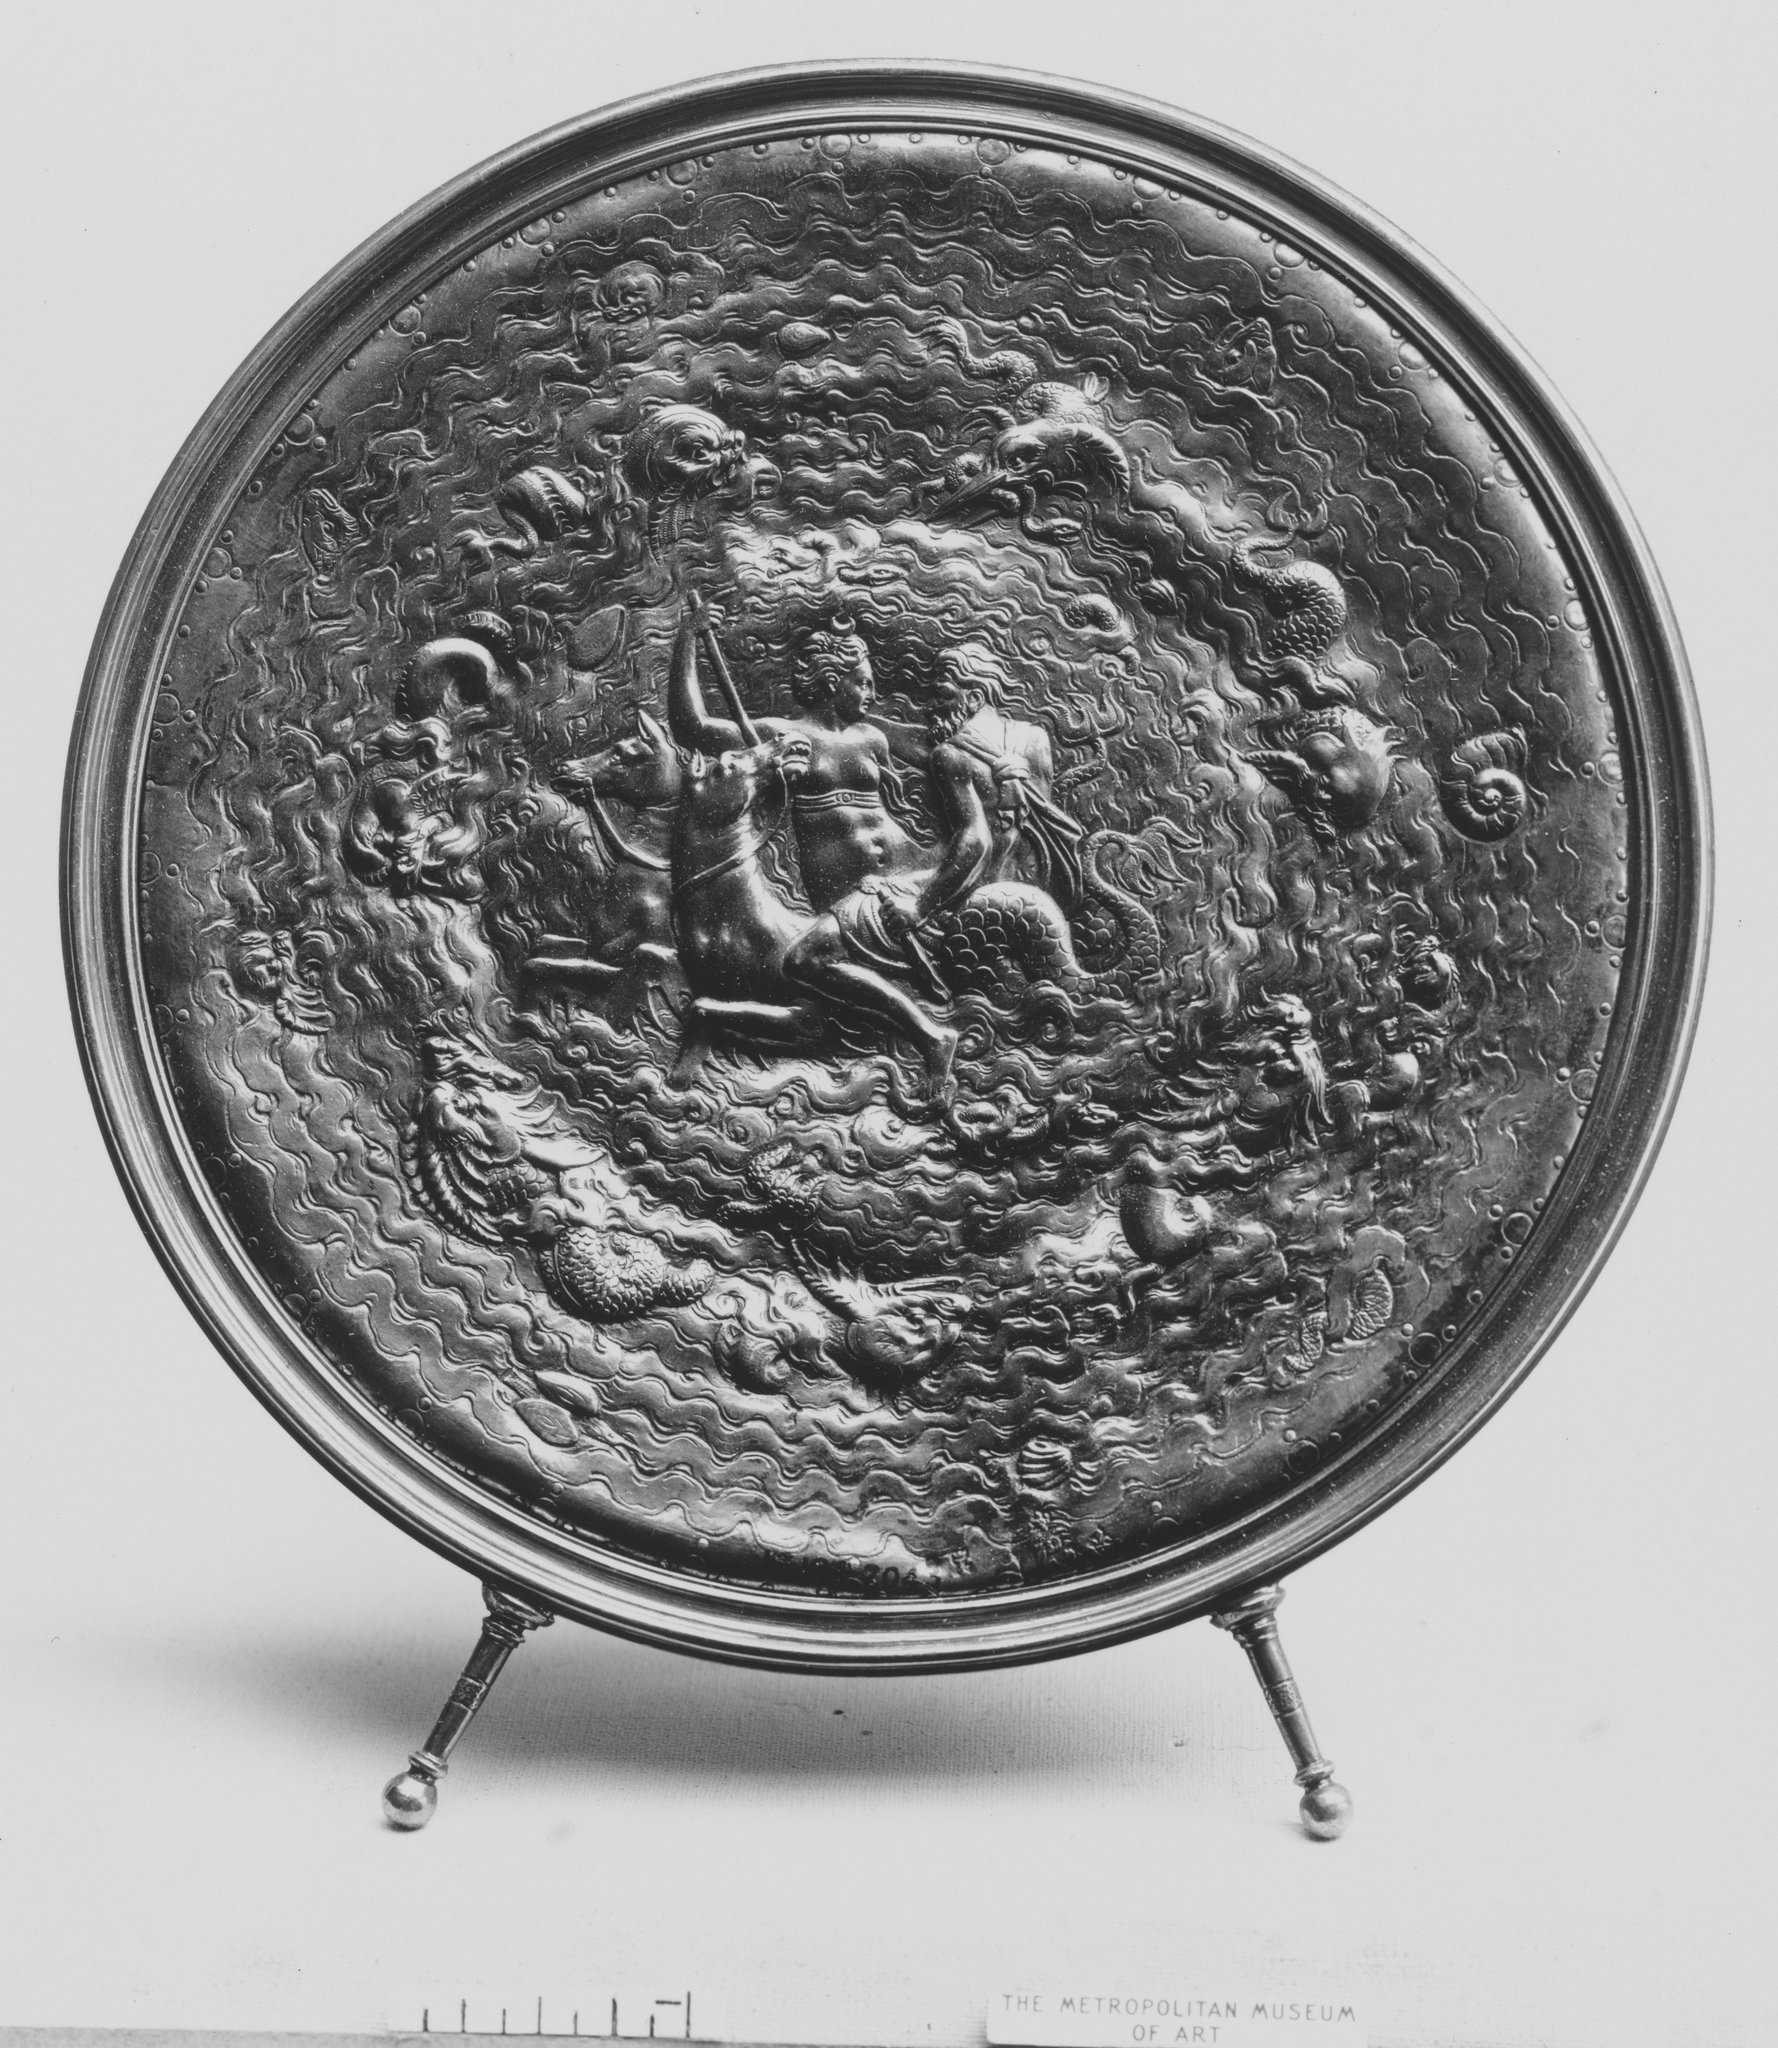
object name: plaque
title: Diana and Neptune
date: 1801-1900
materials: gilt silver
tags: dragons,diana,neptune,horses